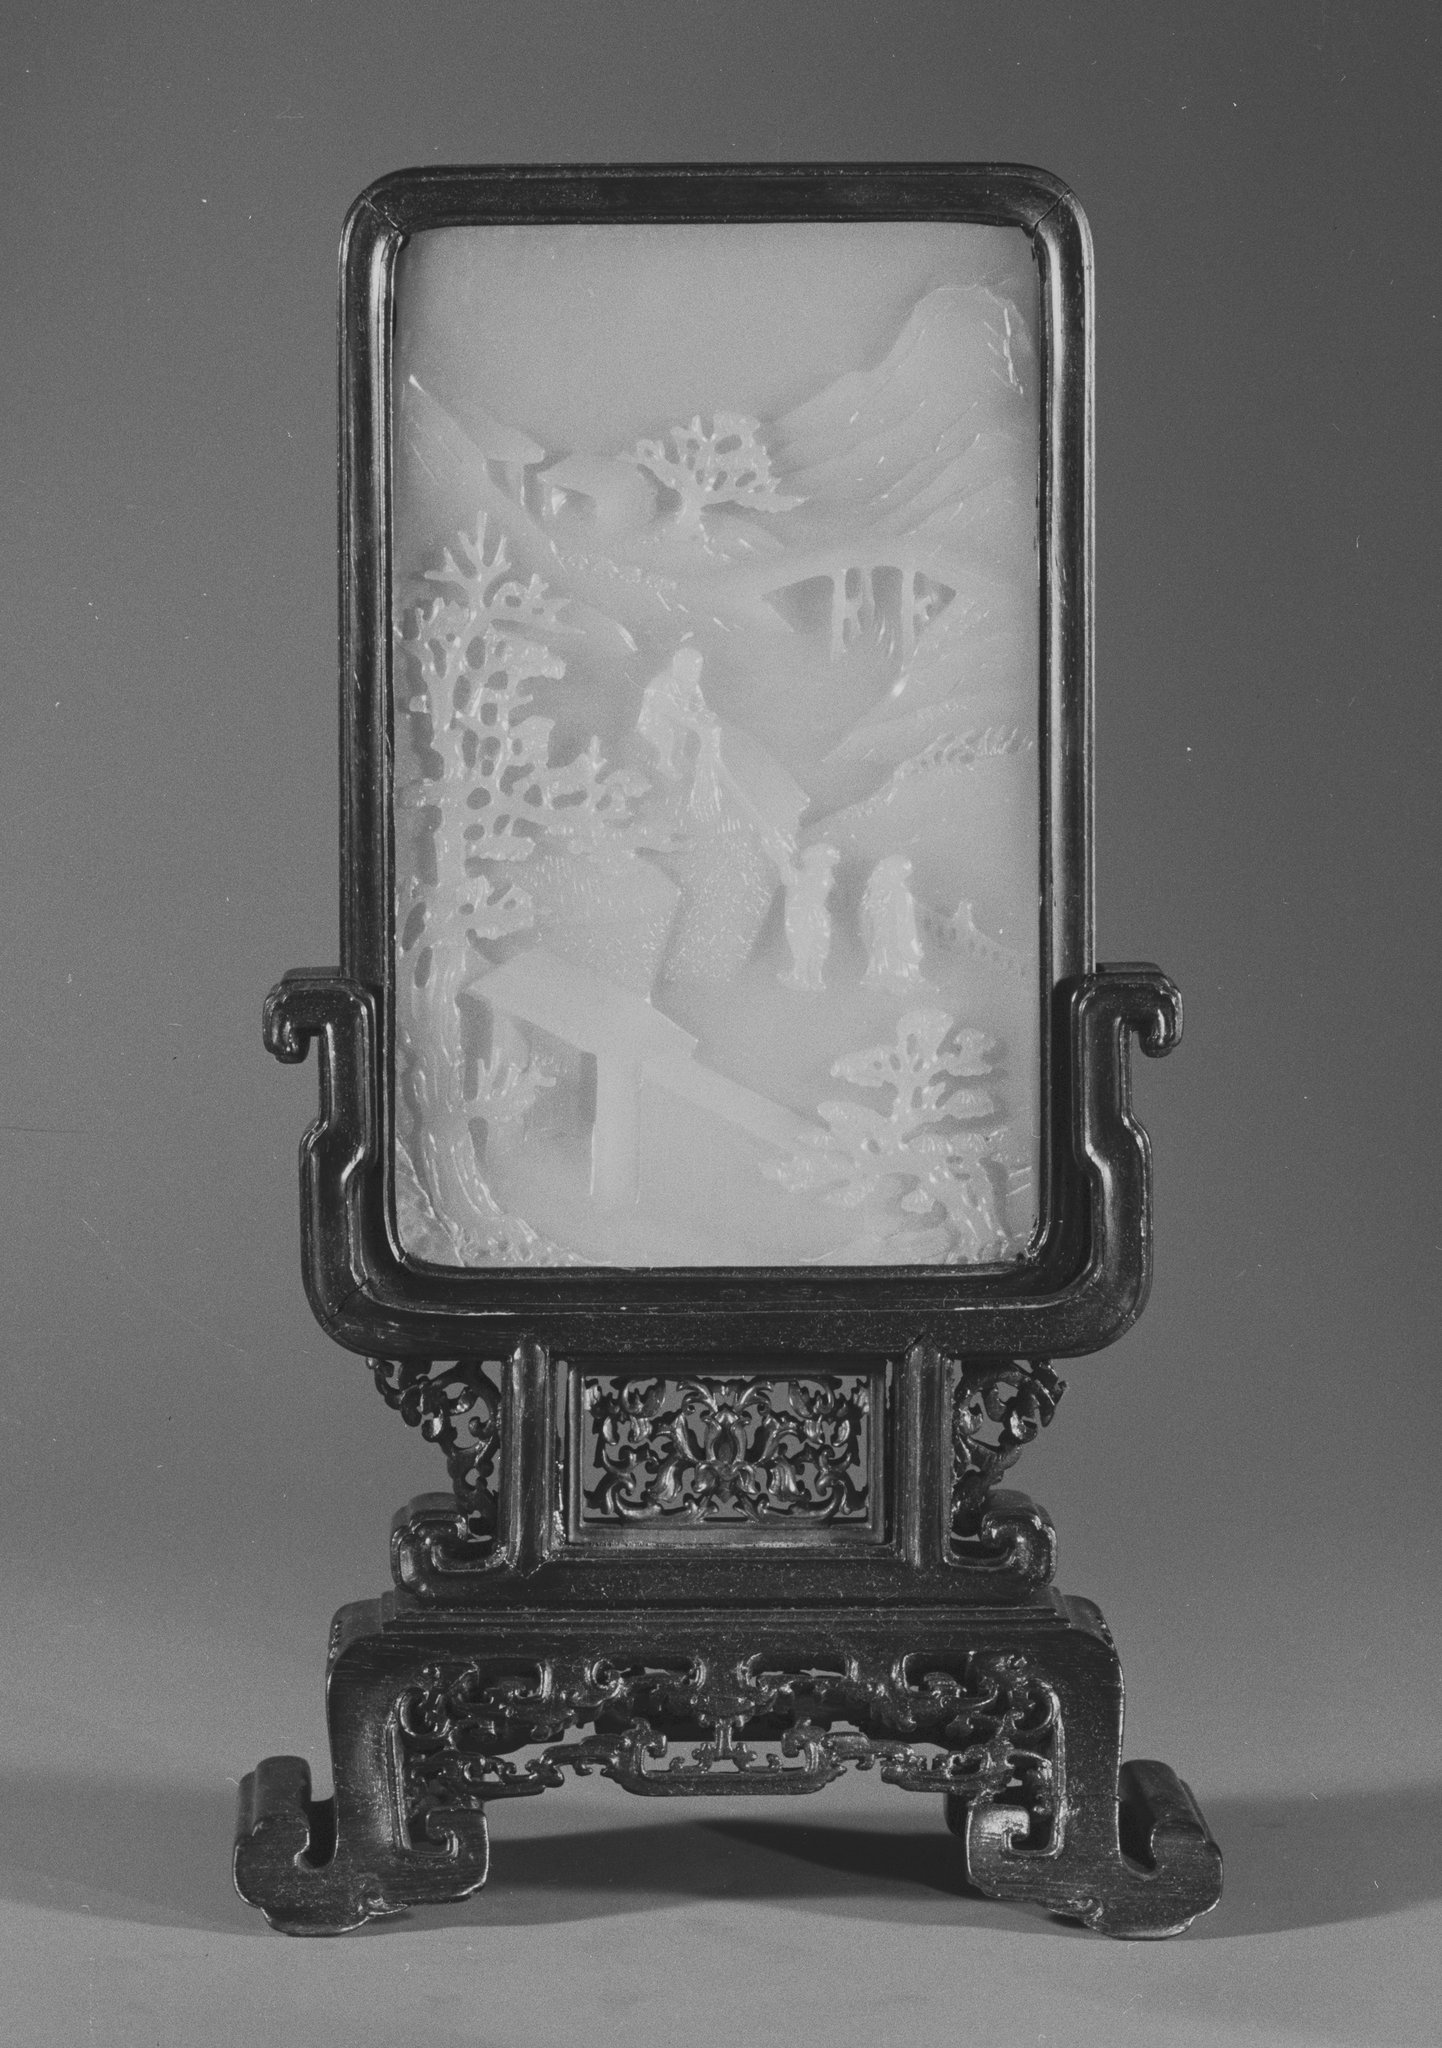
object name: table screen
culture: chinese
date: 1701-1800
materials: jade, wood